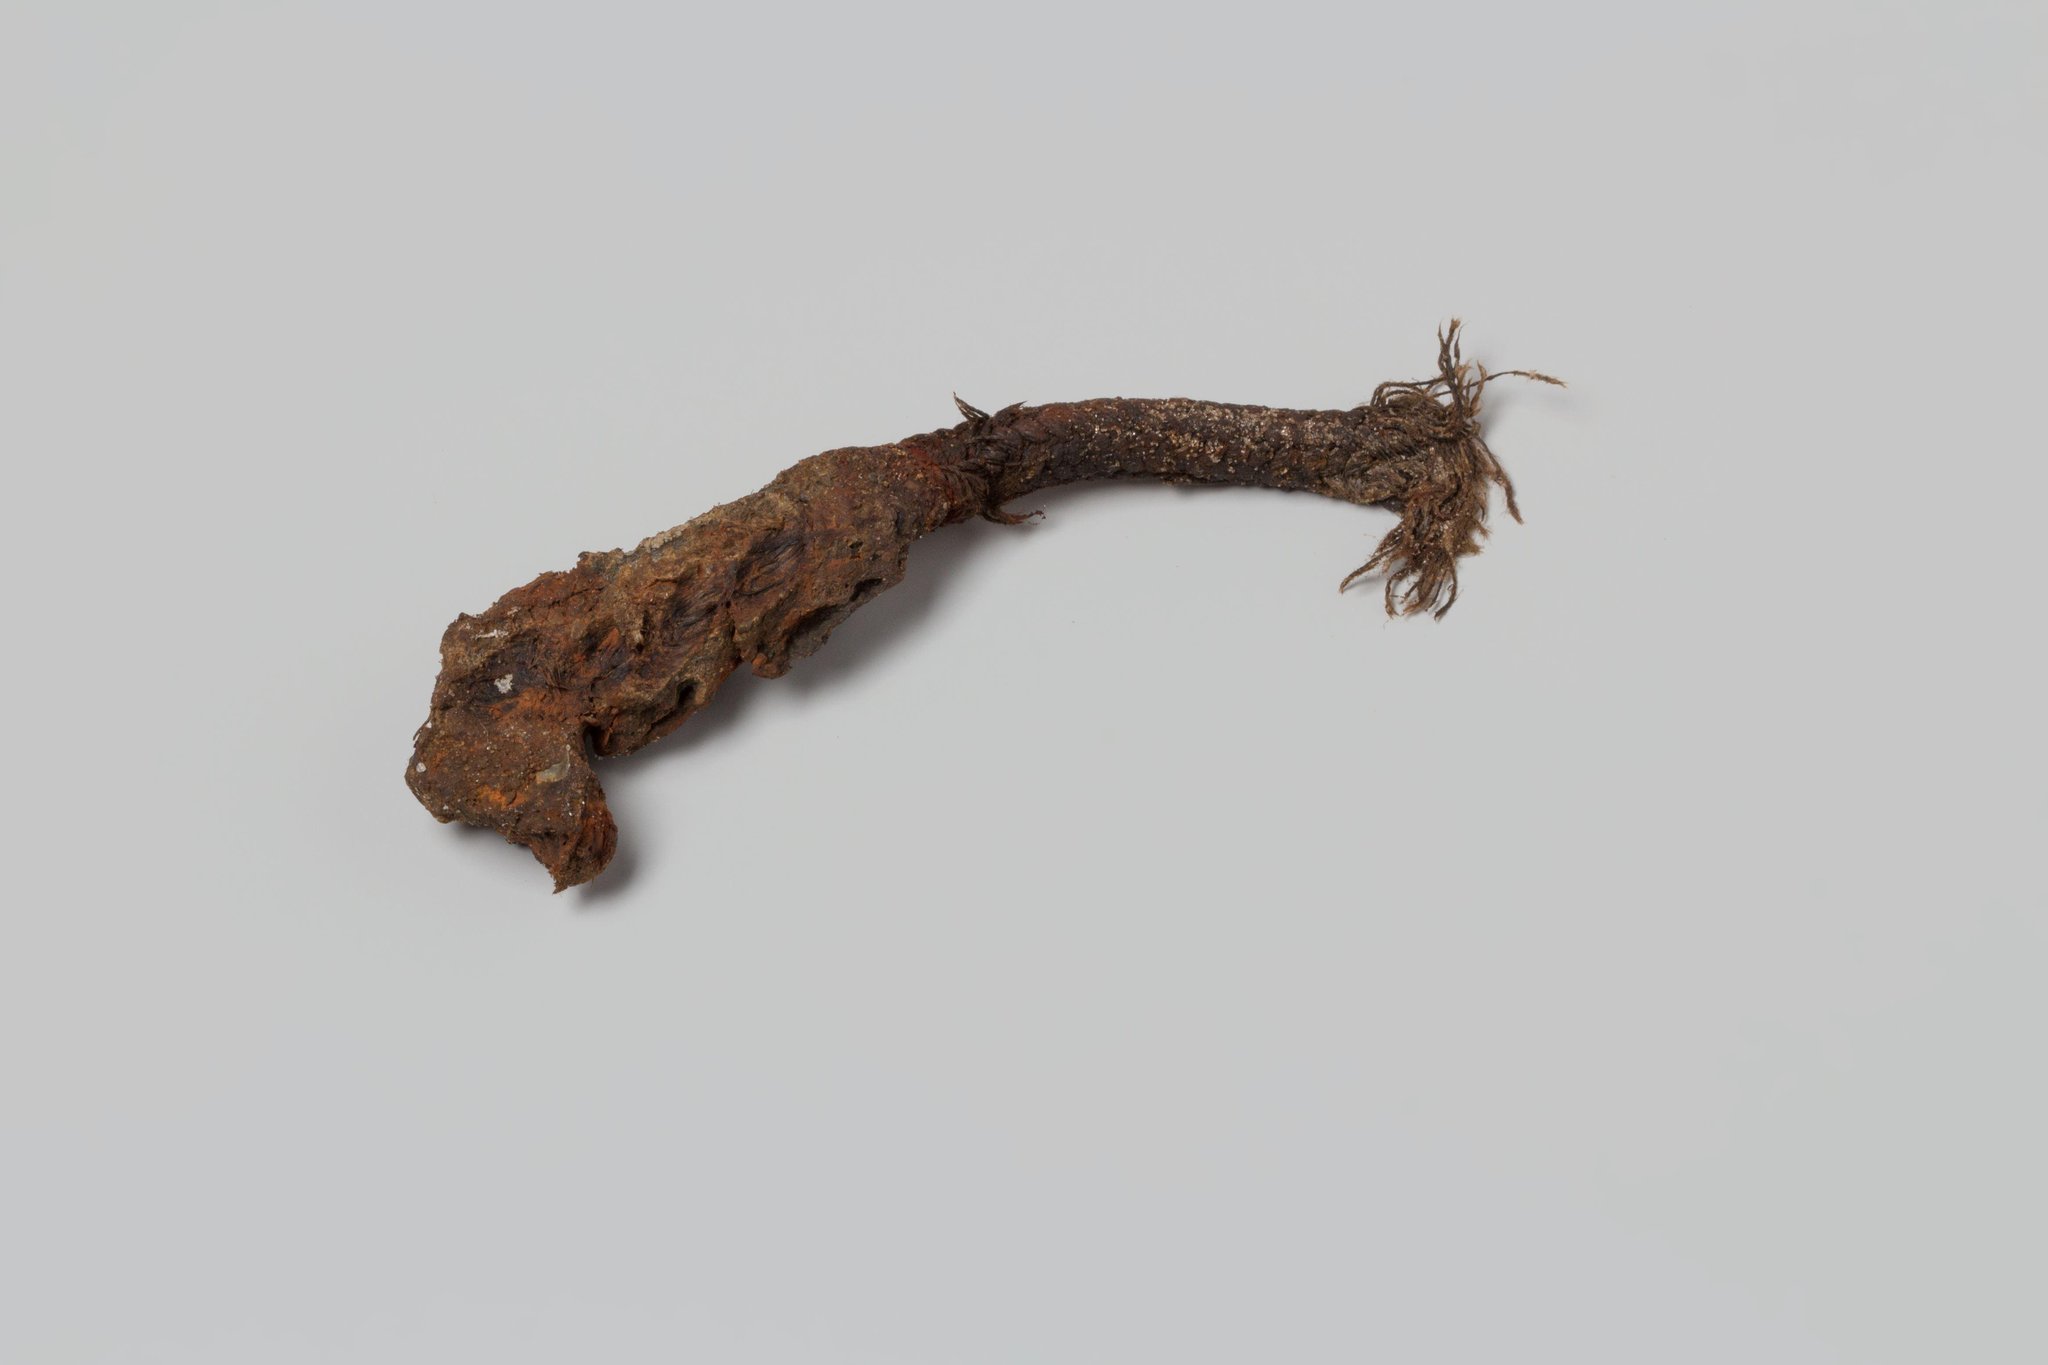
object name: lanyard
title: Fragment van een koord / touw uit het wrak van de Oost-Indiëvaarder 't Vliegend Hart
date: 1700-1735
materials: fiber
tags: 't vliegend hart (schip), verenigde oostindische compagnie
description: Het bruine koordfragment is gedeeltelijk opgenomen in een ijzerconcretie.